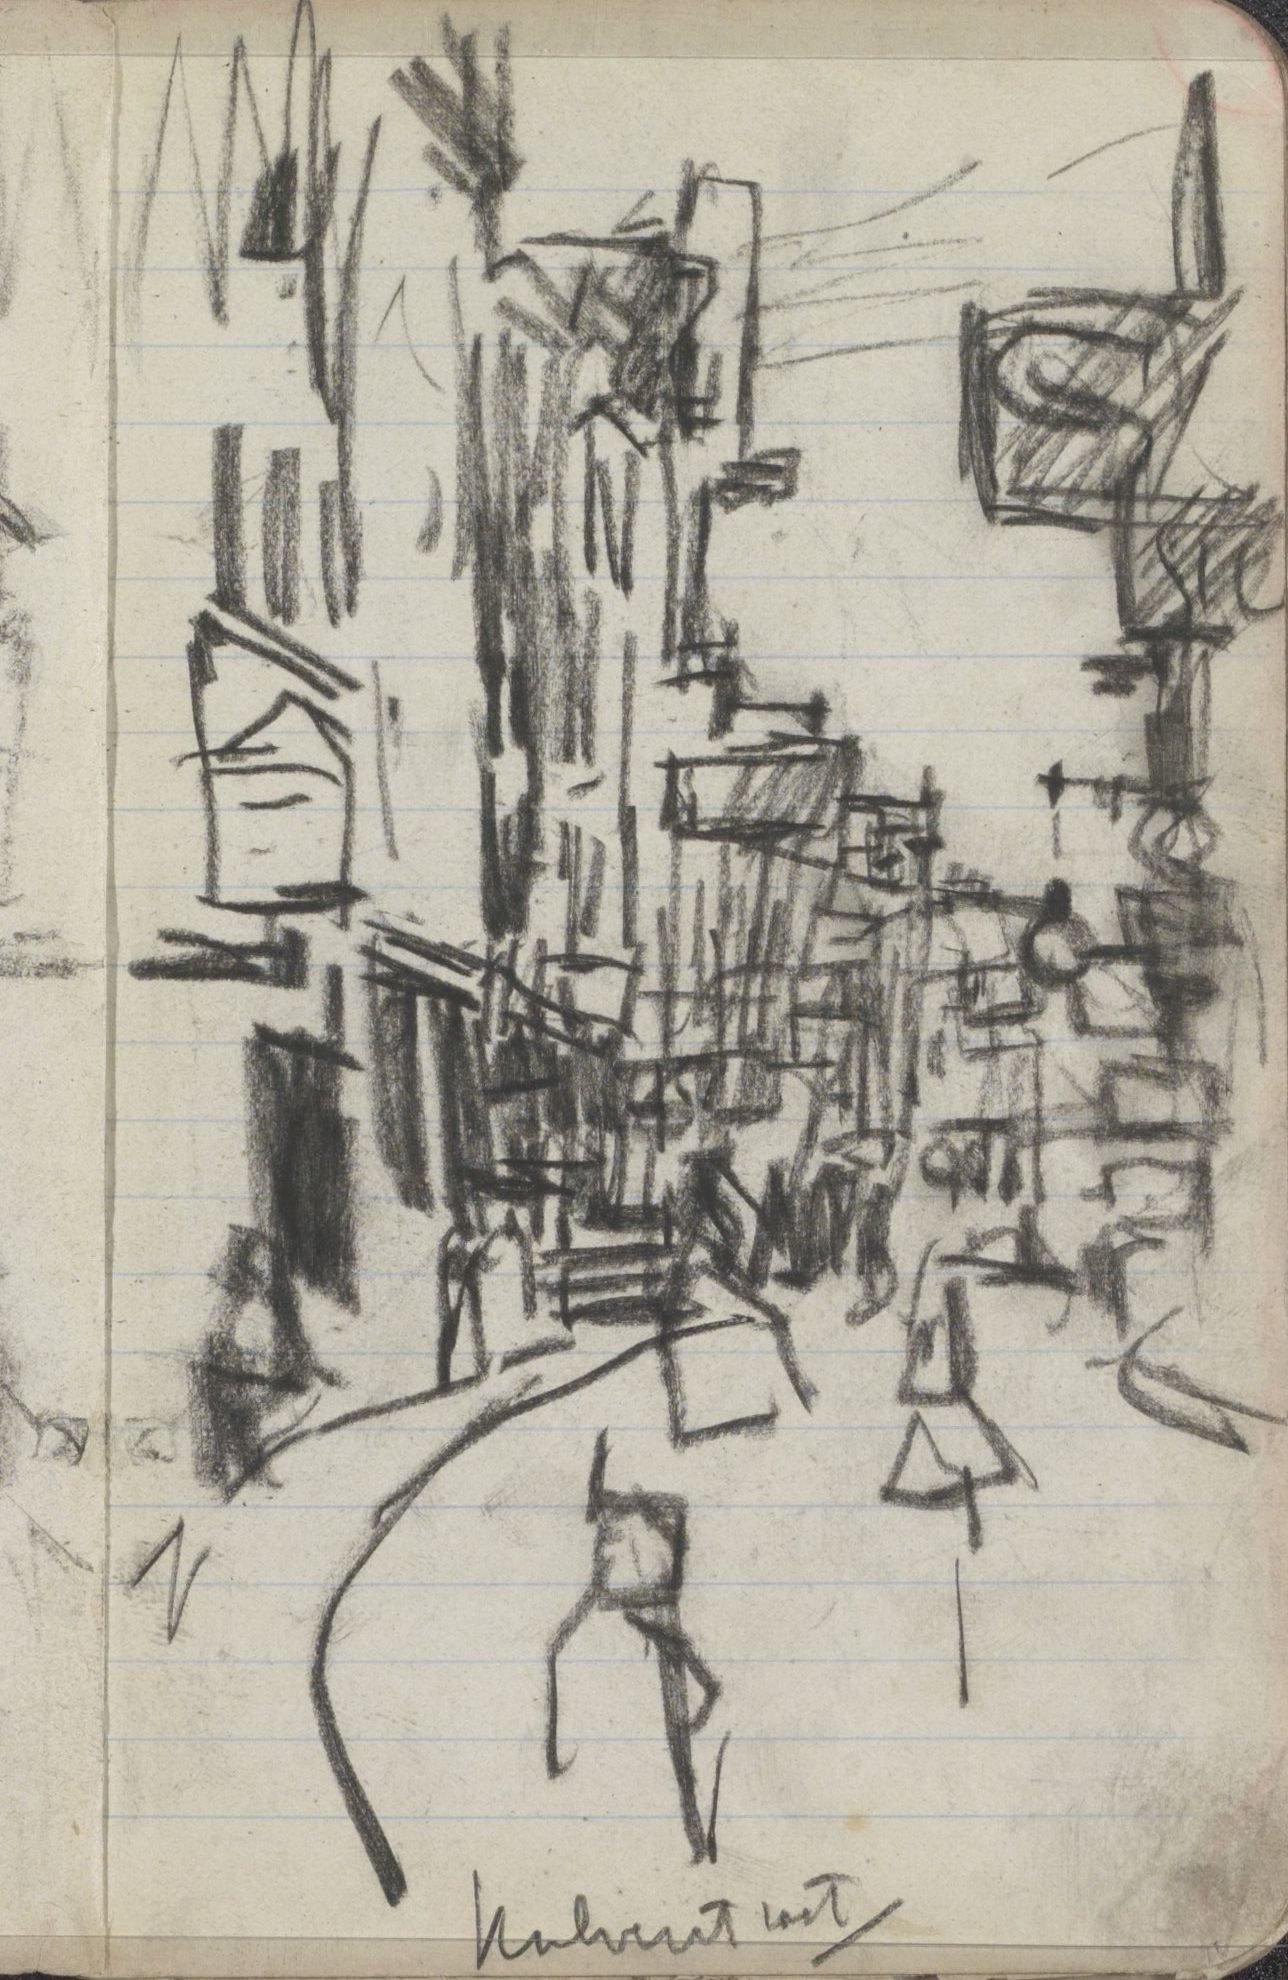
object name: sketchbook leaf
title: Gezicht op de Kalverstraat te Amsterdam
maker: george hendrik breitner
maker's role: draughtsman, painter, print maker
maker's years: 1857-1923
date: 1892-1900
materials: chalk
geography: amsterdam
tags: civic architecture; edifices; dwellings, street (+ city(-scape) with figures, staffage)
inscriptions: annotation: ‘Kalverstraat’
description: Pagina 4 uit een schetsboek met 38 bladen.